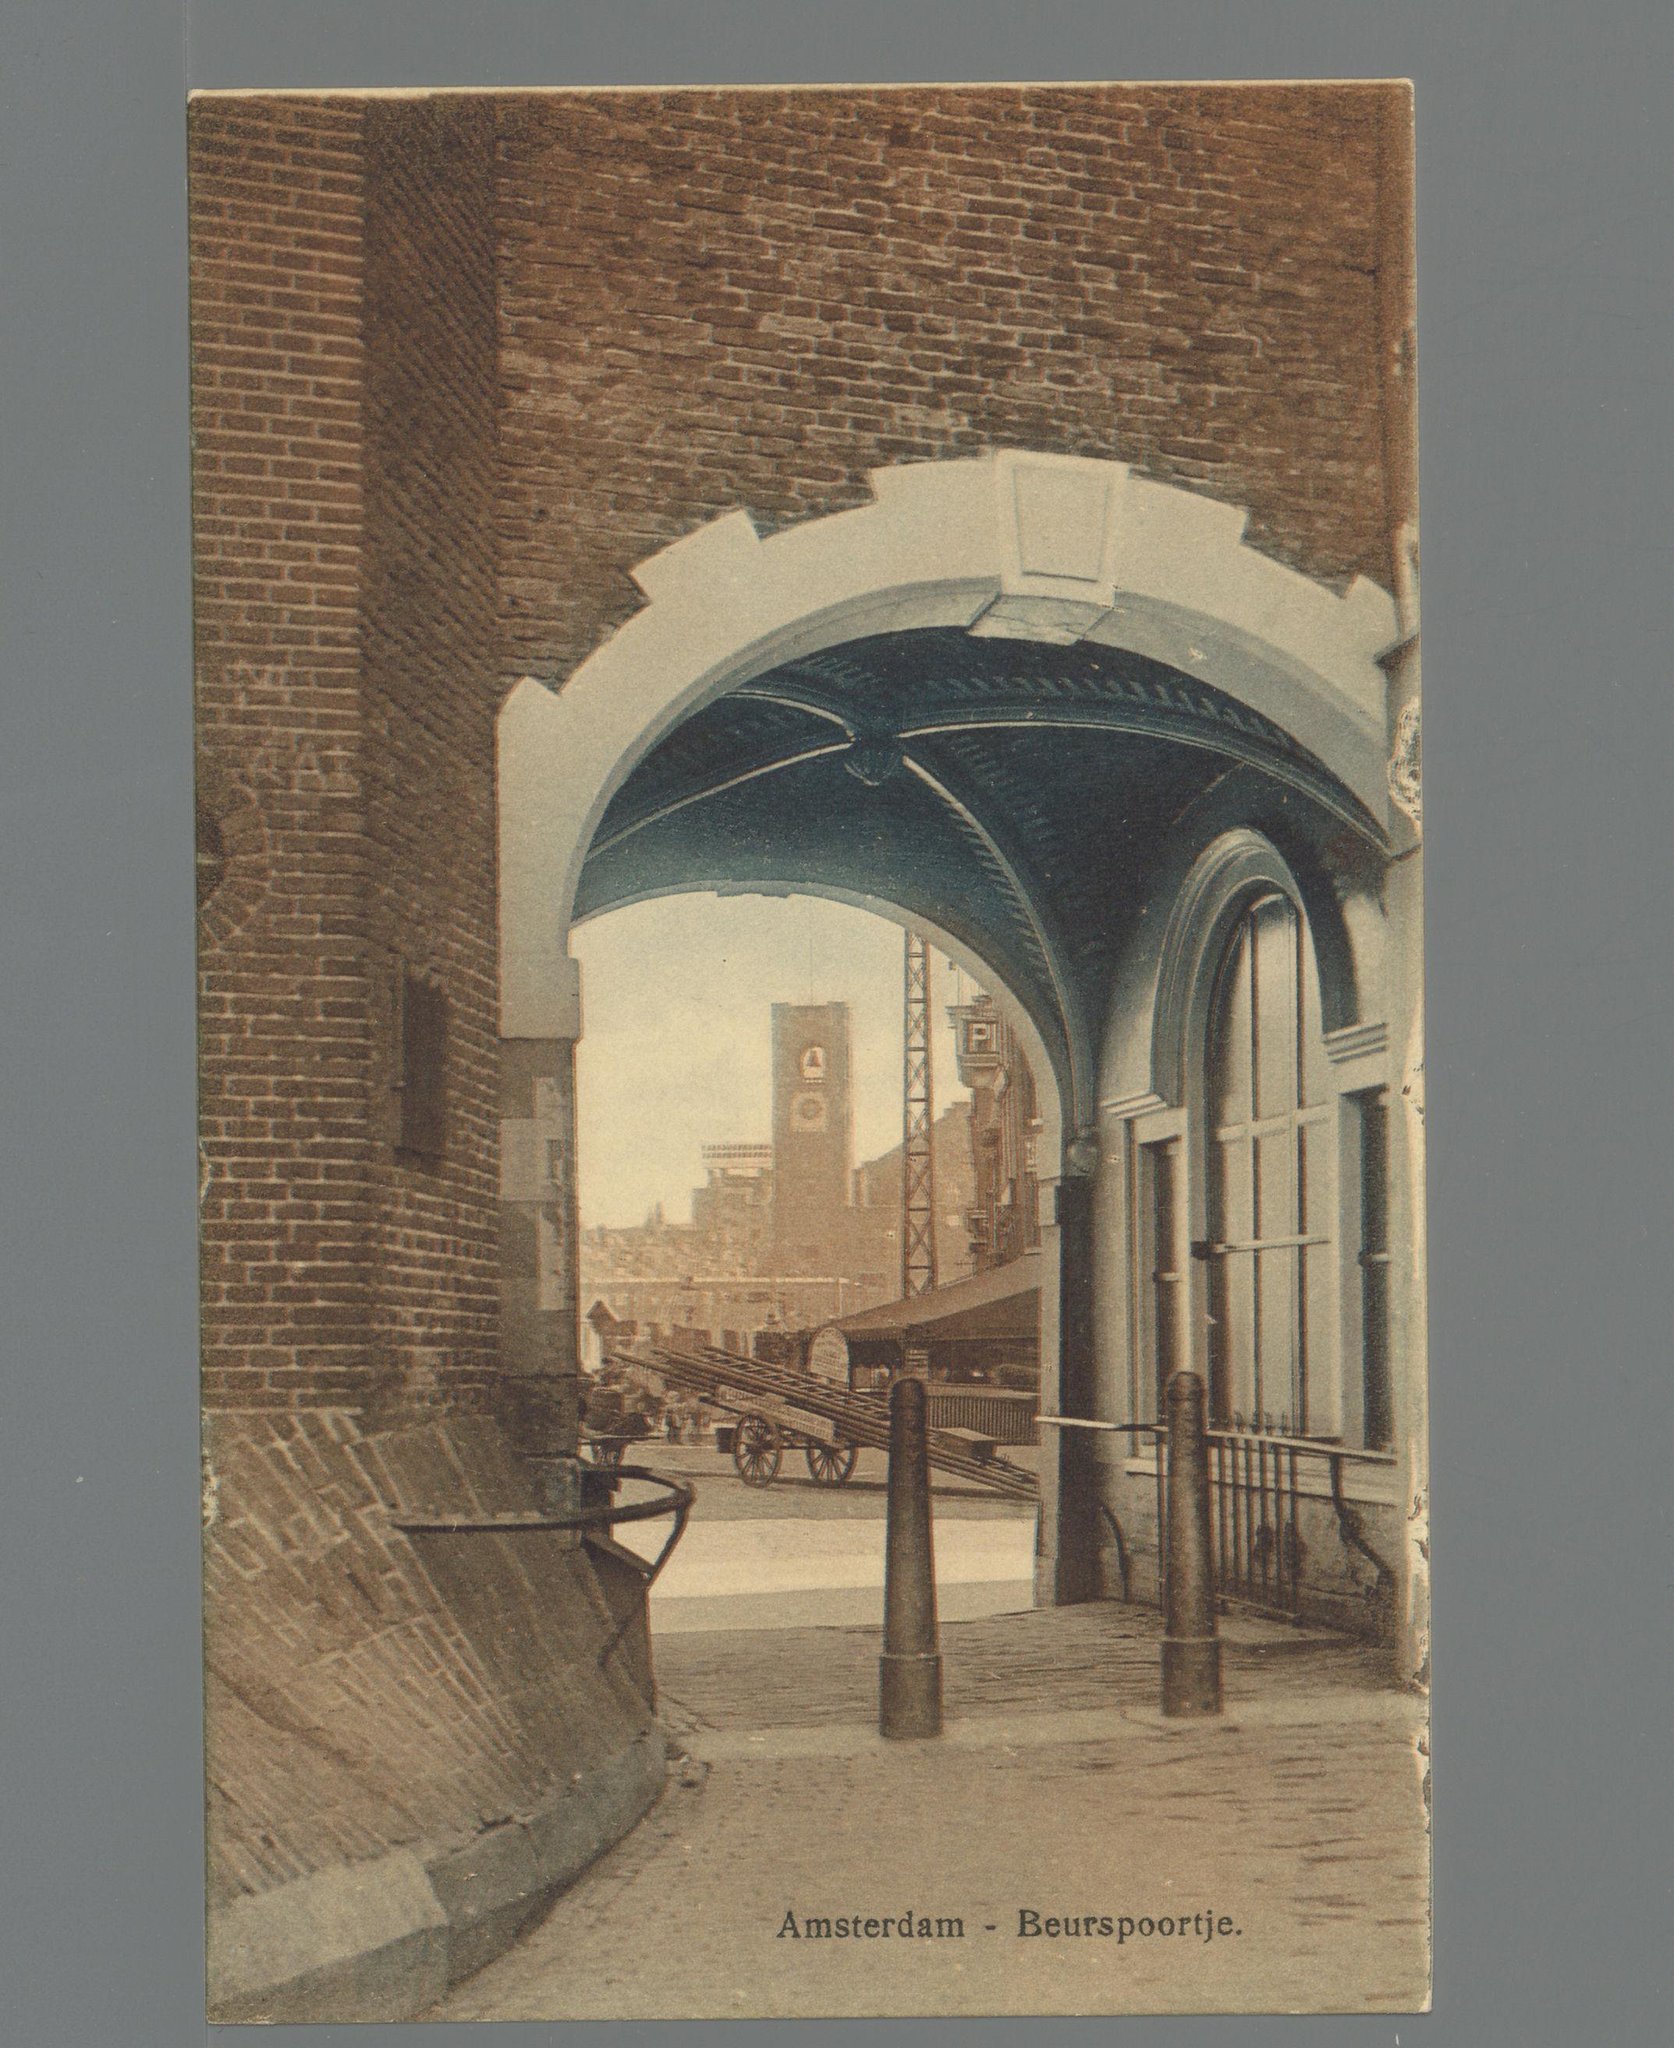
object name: ansichtkaart, prentbriefkaart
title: Amsterdam - Beurspoortje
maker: Anonymous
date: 1910-1912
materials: cardboard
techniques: collotype process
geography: amsterdam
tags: parts of church exterior and annexes, street, city-gate